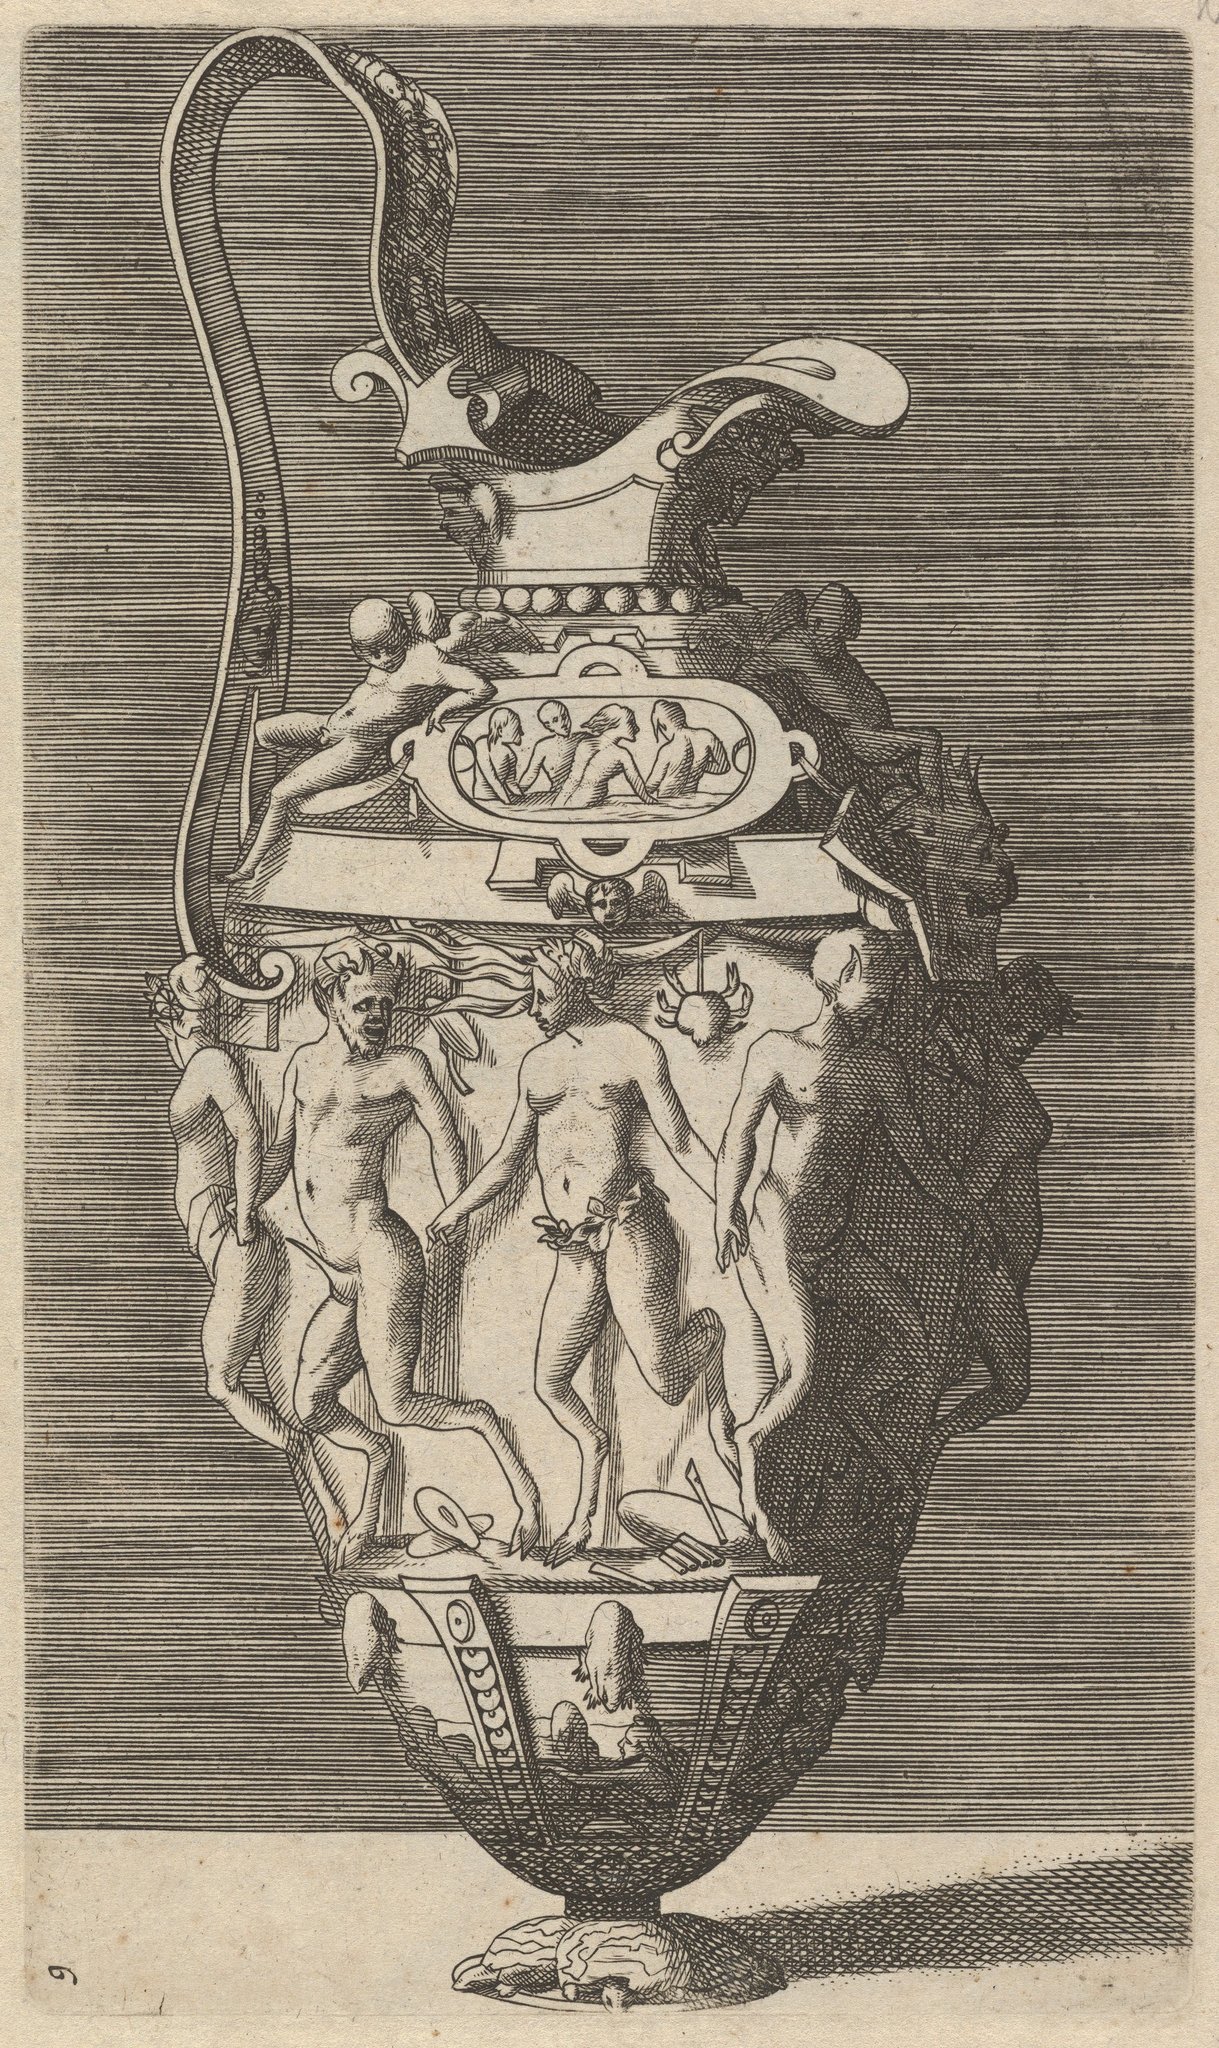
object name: print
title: Vase with Dancing Women and Satyrs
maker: rené boyvin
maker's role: artist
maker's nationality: french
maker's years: 1525-1598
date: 1601-1700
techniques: engraving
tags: women,dancing,satyrs,vases